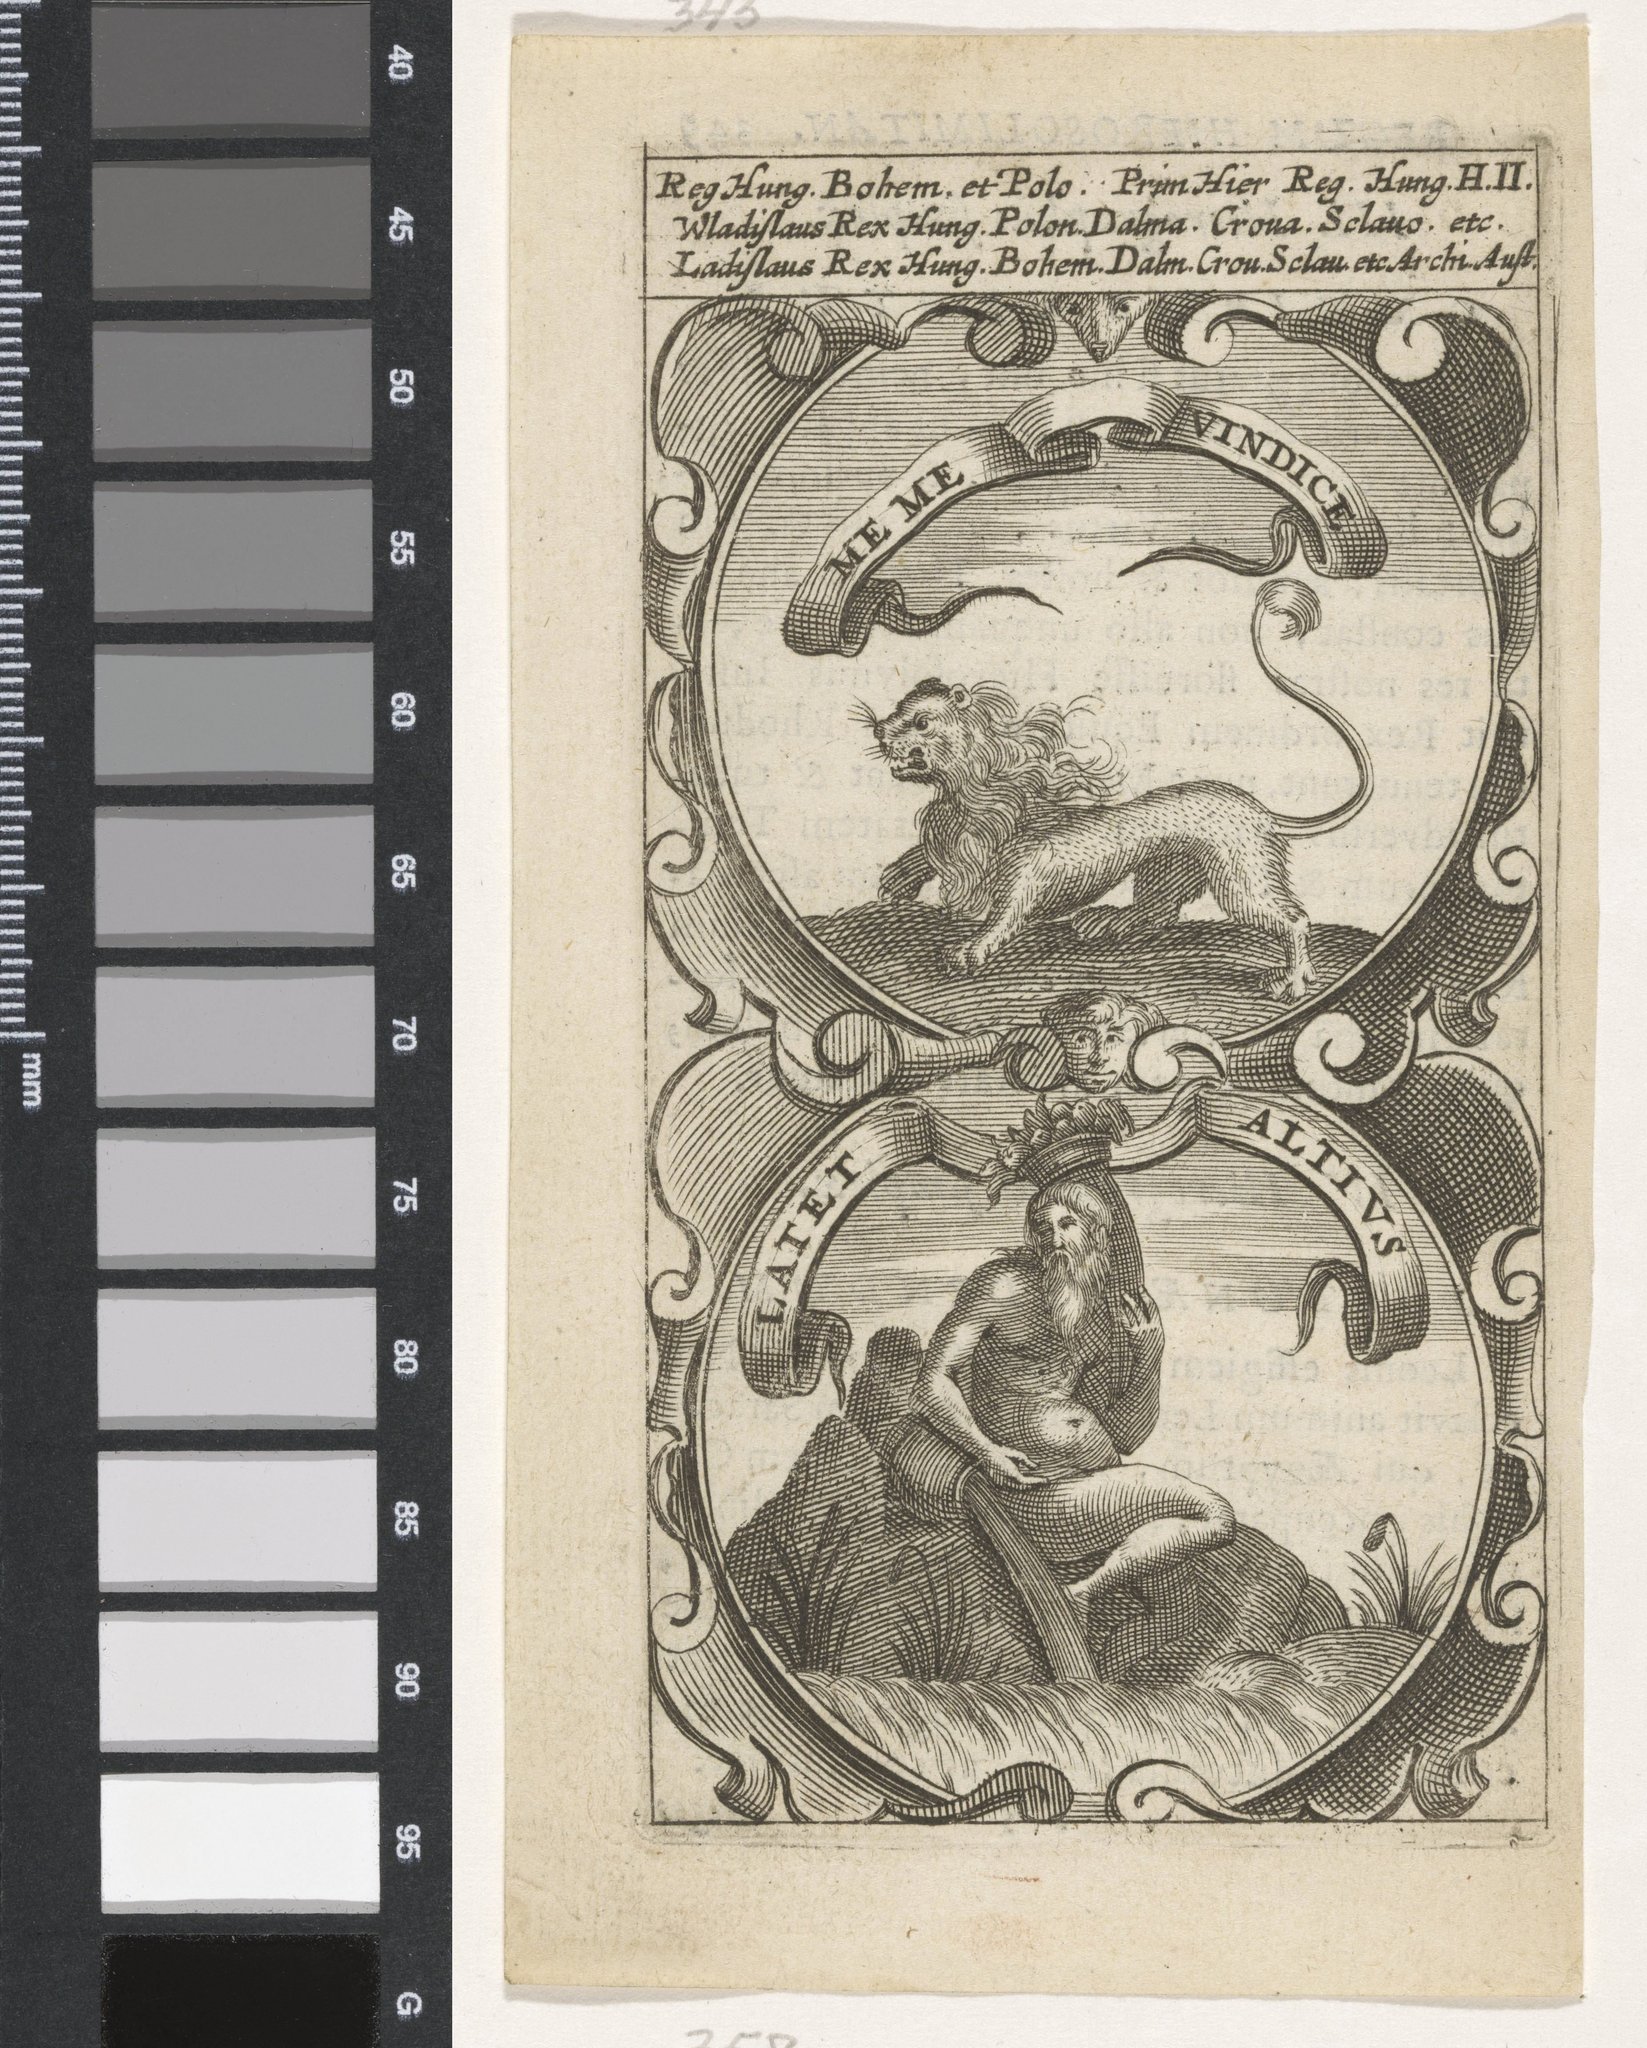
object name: print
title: Symbola Divina et Humana Pontificum Imperatorum Regum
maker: Anonymous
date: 1666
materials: paper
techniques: engraving, letterpress printing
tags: 'cornucopia', horn of plenty, river-gods, beasts of prey, predatory animals: lion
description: Een embleem met twee voorstellingen. Boven een leeuw in dreigende houding. Onder een riviergod bij het water. In zijn handen een kruik en een hoorn des overvloeds. Het betreffen deviezen van Wladislaus I en Ladislaus Posthumus van Hongarije.